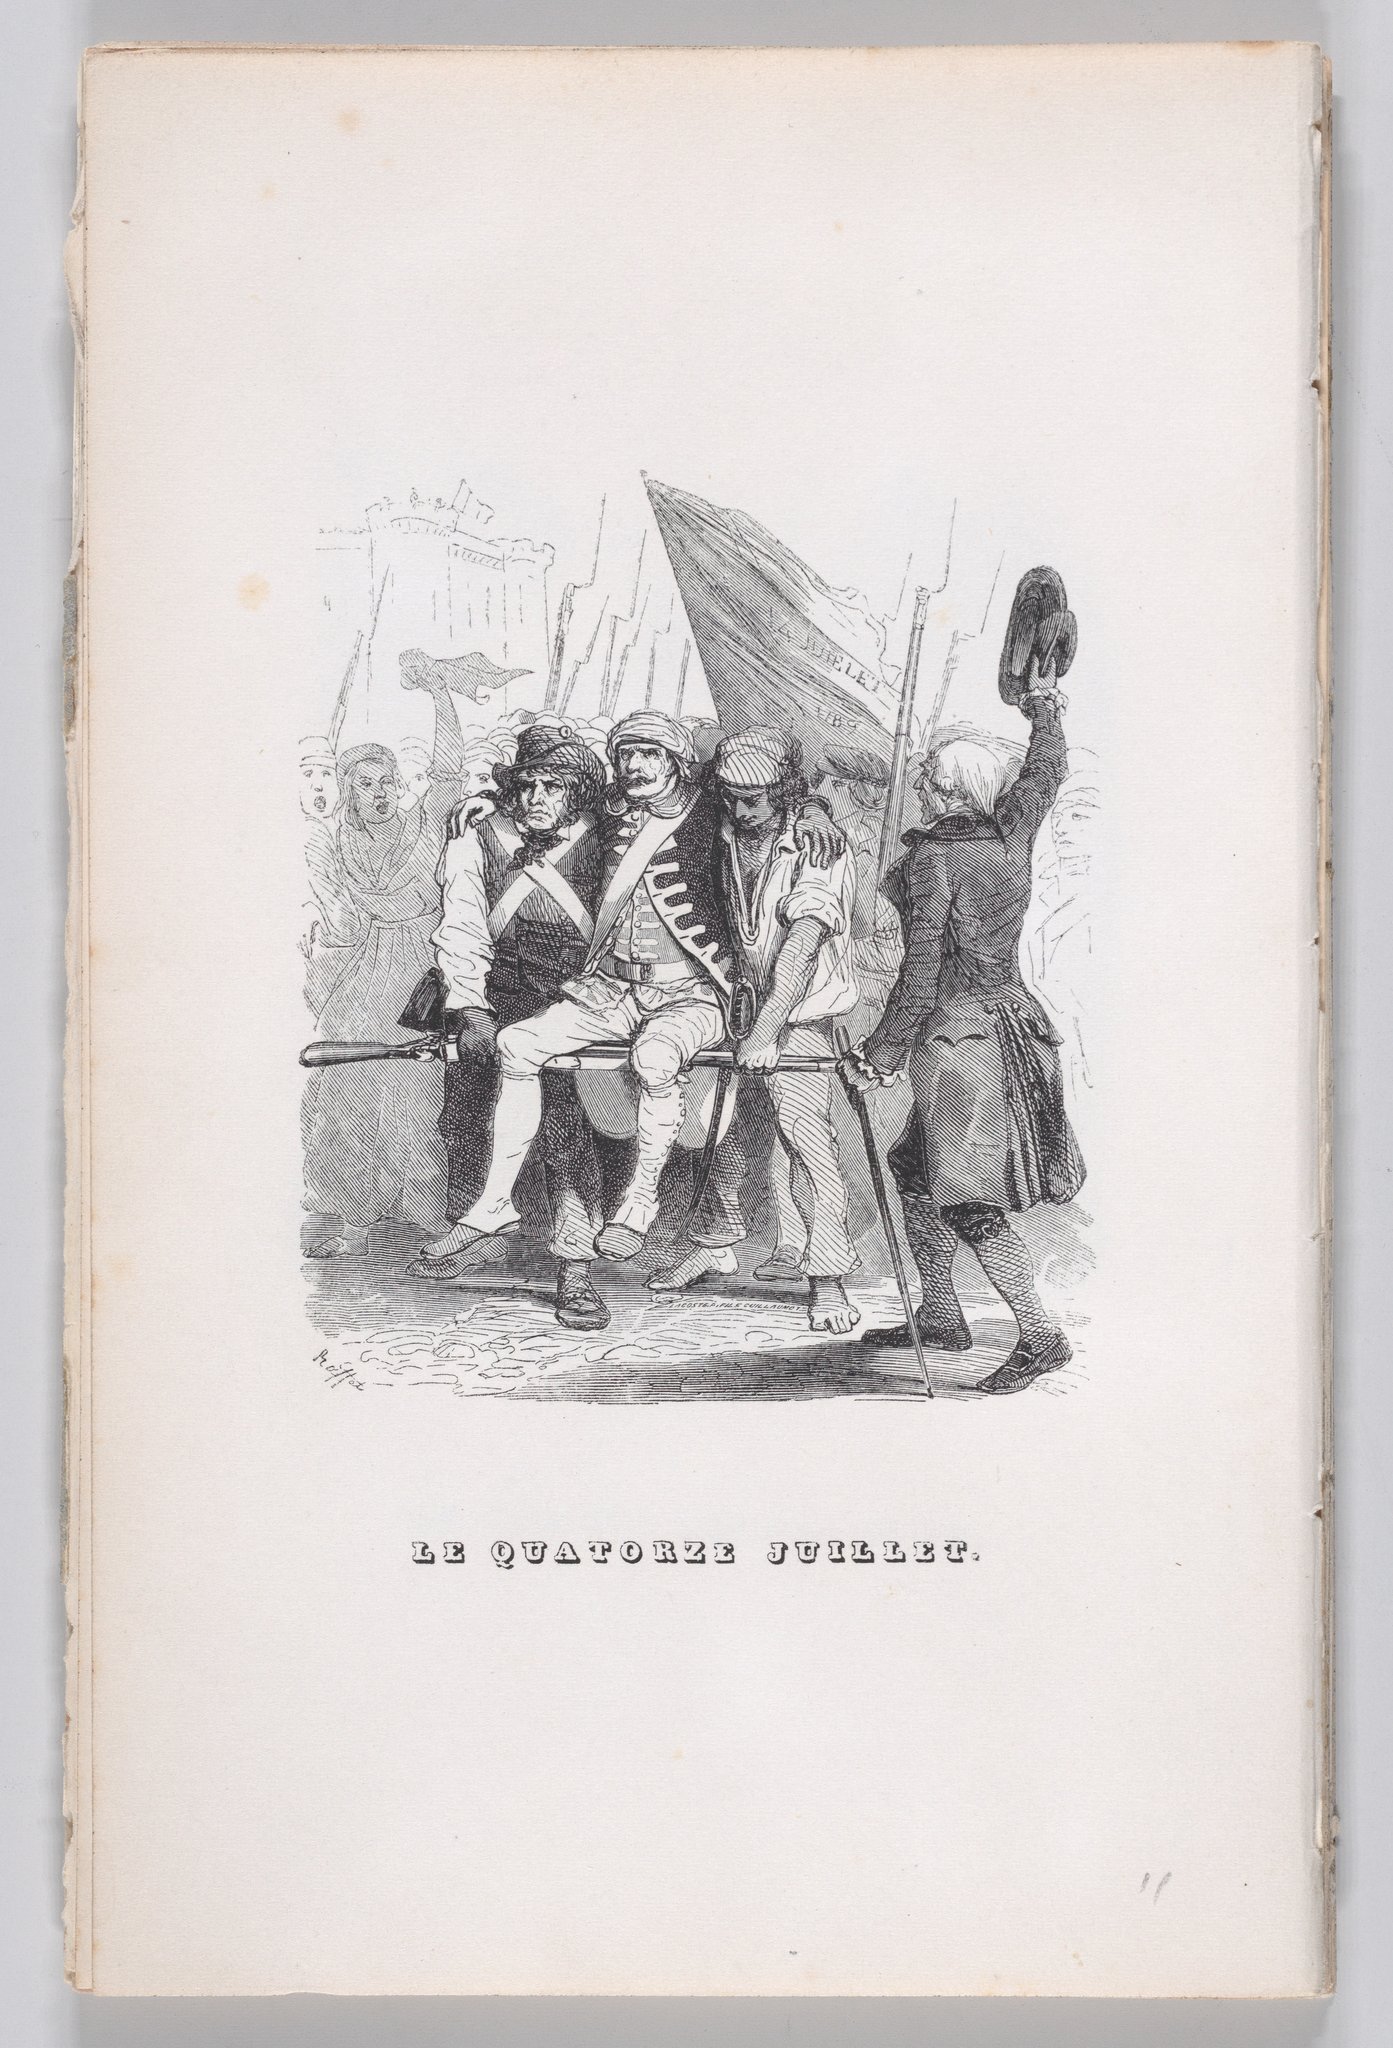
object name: print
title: July Fourteenth, from "The Complete Works of Béranger"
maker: auguste raffet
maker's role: engraver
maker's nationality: french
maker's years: 1804-1860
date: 1836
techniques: engraving